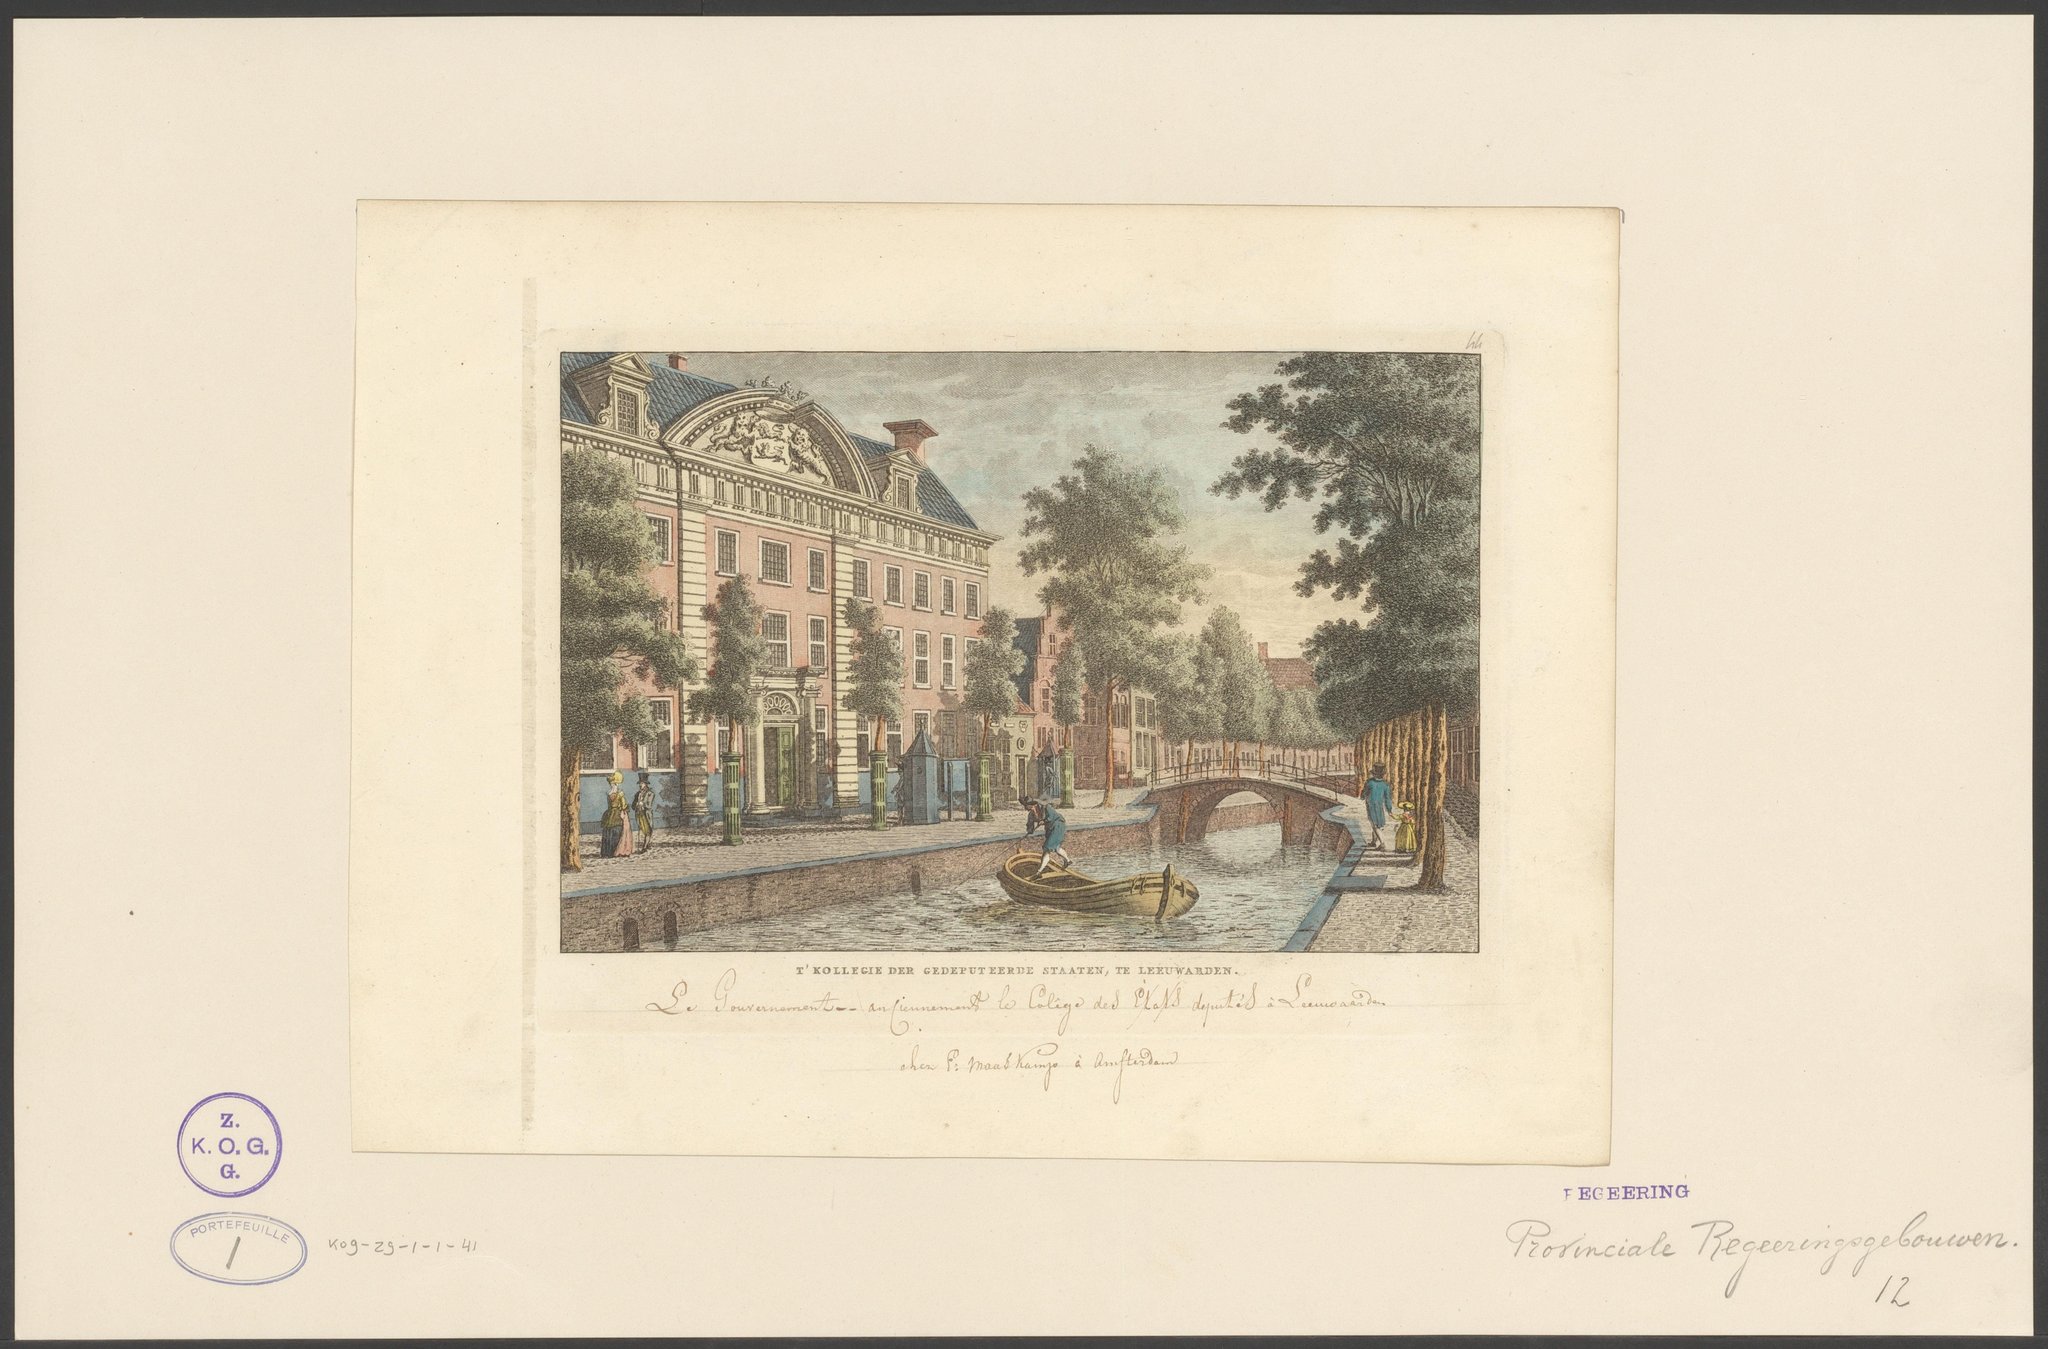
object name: print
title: T'Kollegie der Gedeputeerde Staaten, te Leeuwarden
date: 1786-1792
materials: paper, watercolor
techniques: etching, hand coloring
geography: amsterdam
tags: provincial government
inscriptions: collector's mark, inscription: ‘Le Gouvernement - anciennement le Colêge des Etats députés à Leeuwaarden / chez E: Maaskamp à Amsterdam’, collector's mark: Lugt 1641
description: Huidige staat van prent uitgegeven als onderdeel van een plaatwerk uit ca. 1824-1825 met 74 (ongenummerde) platen van de belangrijkste topografische gezichten en verschillende zeden en gewoonten in het Verenigd Koninkrijk der Nederlanden, getiteld 'Tableau des principales vues des palais et édifices : représentations et des coutumes et usages, dans les provinces septentrionales du Royaume des Pays-Bas'. Eerdere staat gebruikt in: Vaderlandsche gezichten, of afbeeldingen van den tegenwoordigen staat der Vereenigde Nederlanden (…). Amsterdam: Hendrik Gartman, Willem Vermandel en Jan Willem Smit, 1786-1792. Uitgegeven in afleveringen met ieder een eigen bifolium en inhoudsopgave. Alle prenten in deze publicatie zijn gegraveerd door Carel Frederik Bendorp (I) en, in de meeste gevallen, gebaseerd op tekeningen van Jan Bulthuis.